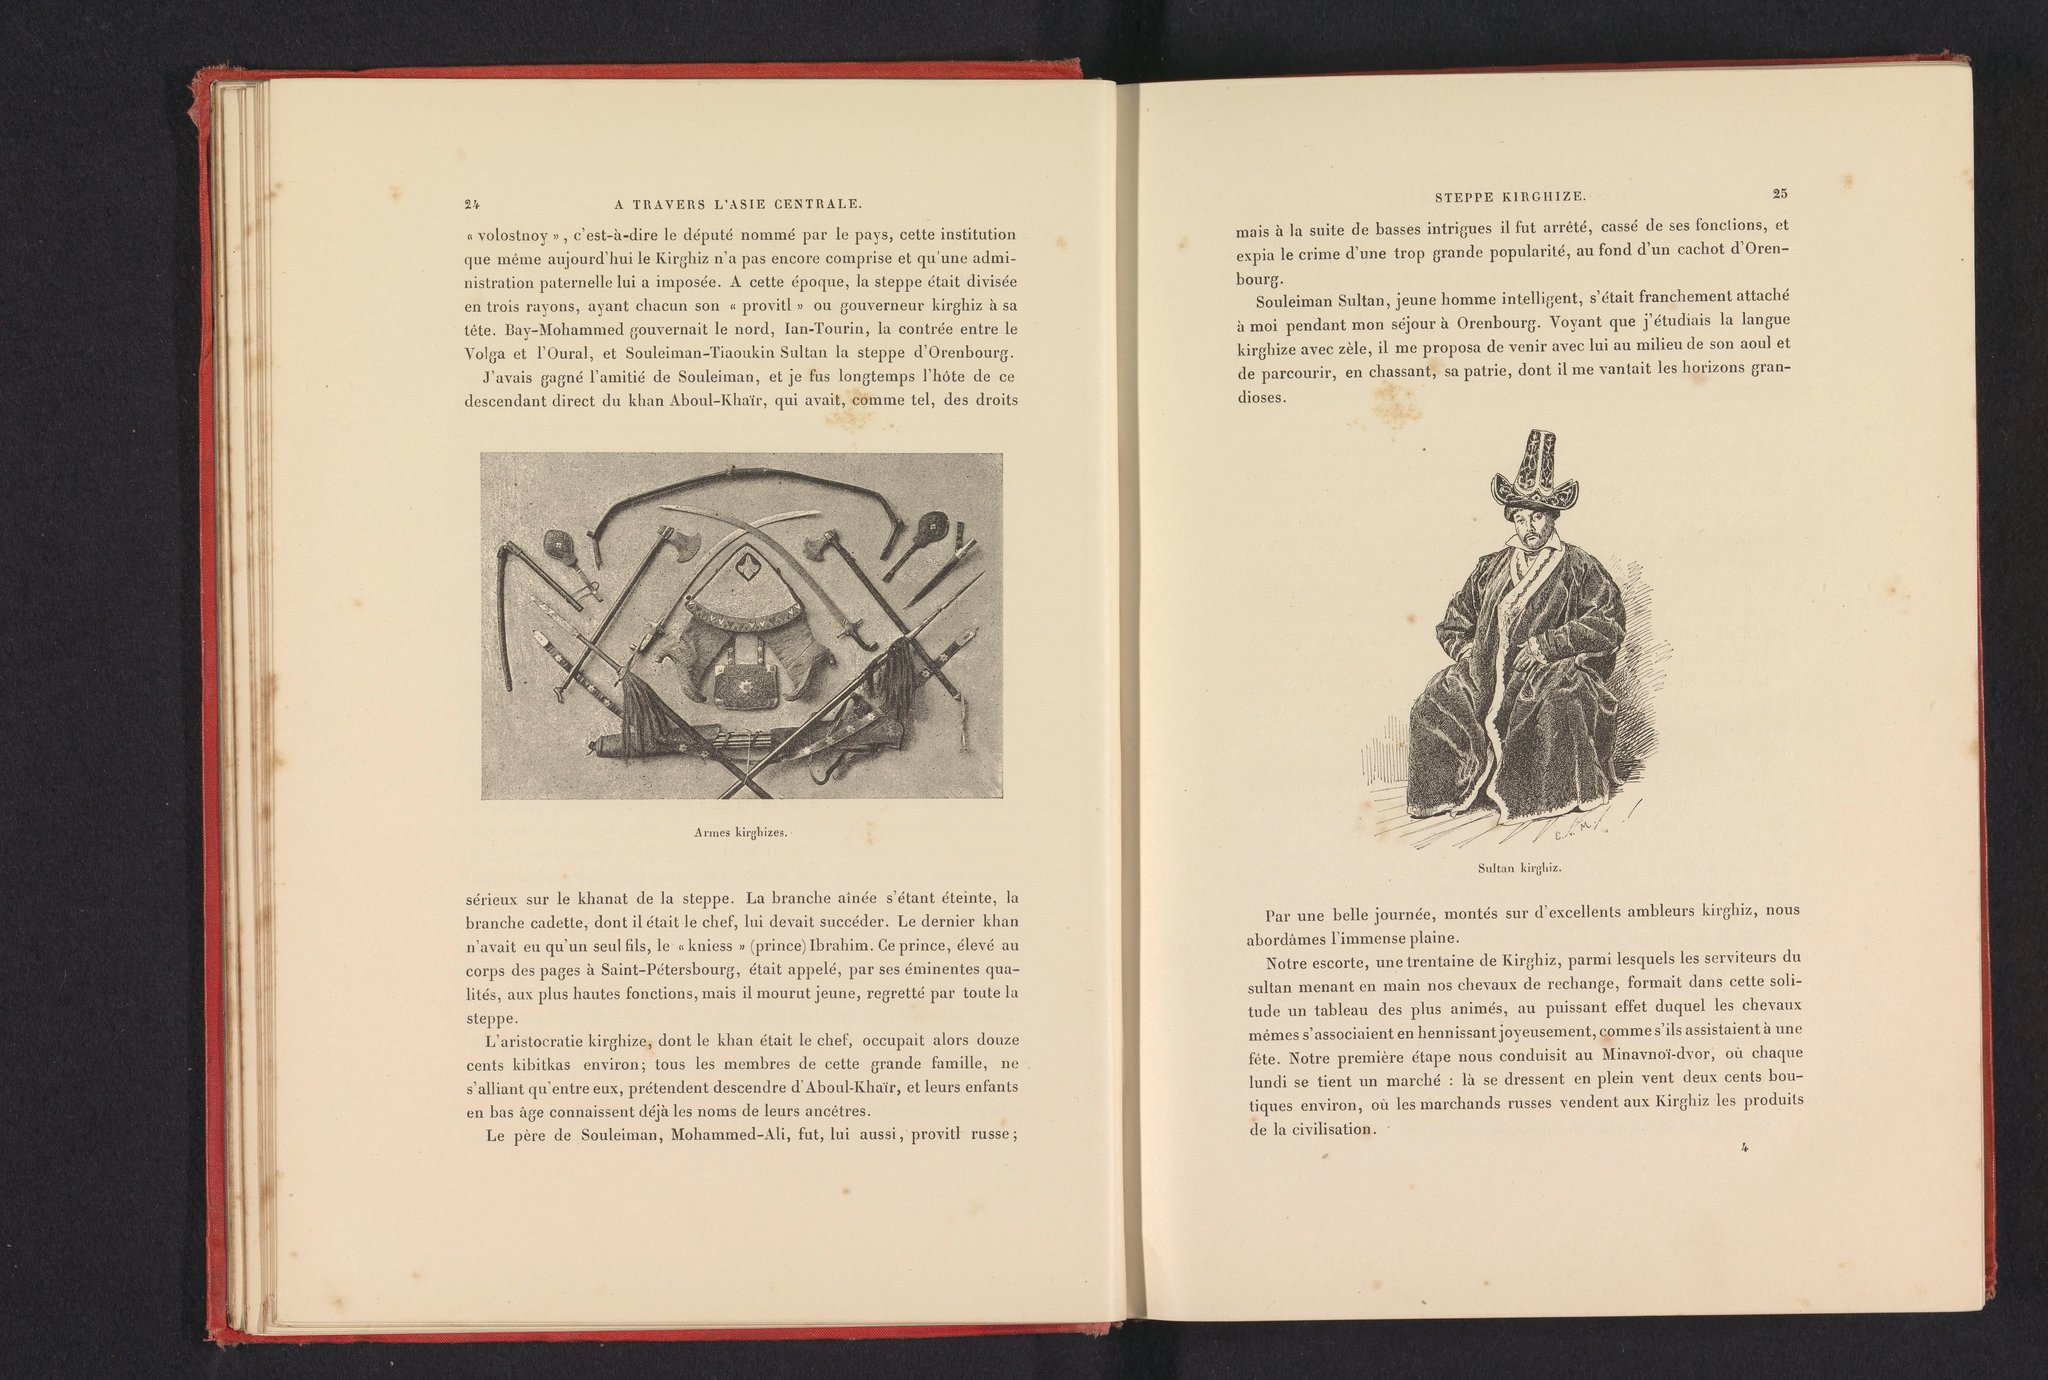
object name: page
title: Armes Kirghizes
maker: Anonymous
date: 1875-1885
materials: paper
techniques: autotype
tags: weapons